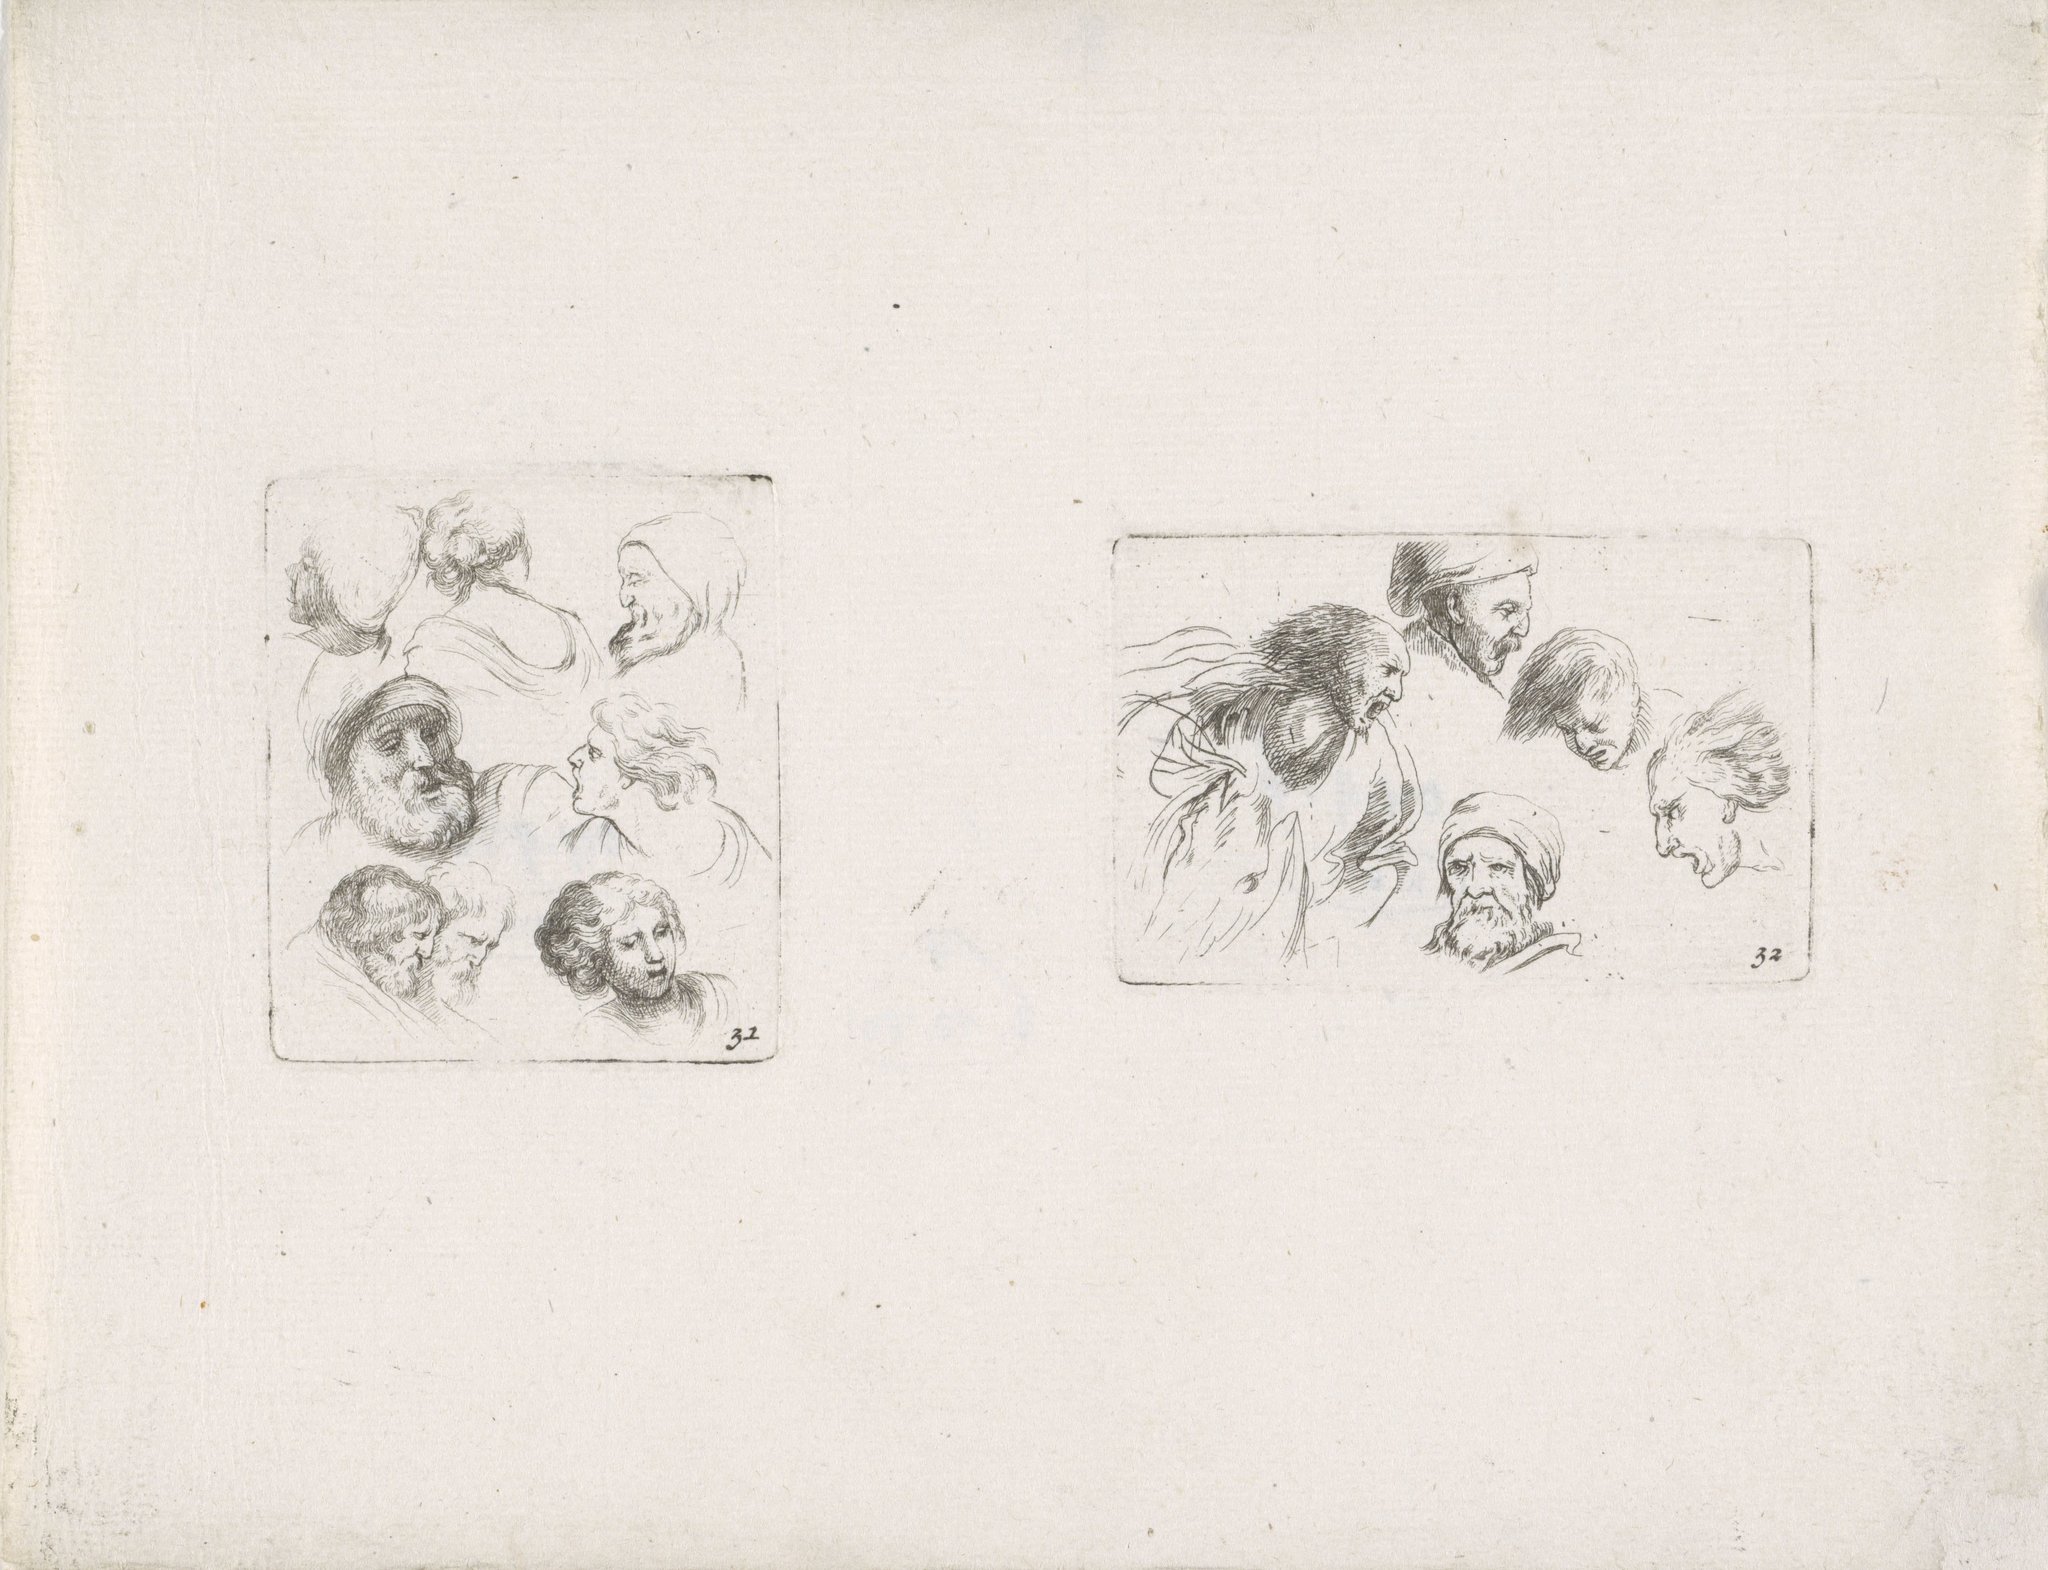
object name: print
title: Tekenvoorbeelden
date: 1620-1664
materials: paper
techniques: etching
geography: amsterdam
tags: riding a horse, ass, or mule; rider, horseman, head (human)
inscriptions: collector's mark: Lugt 2228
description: Blad met twee voorstellingen. Links: acht hoofden. Rechts: vier hoofden en één man te paard